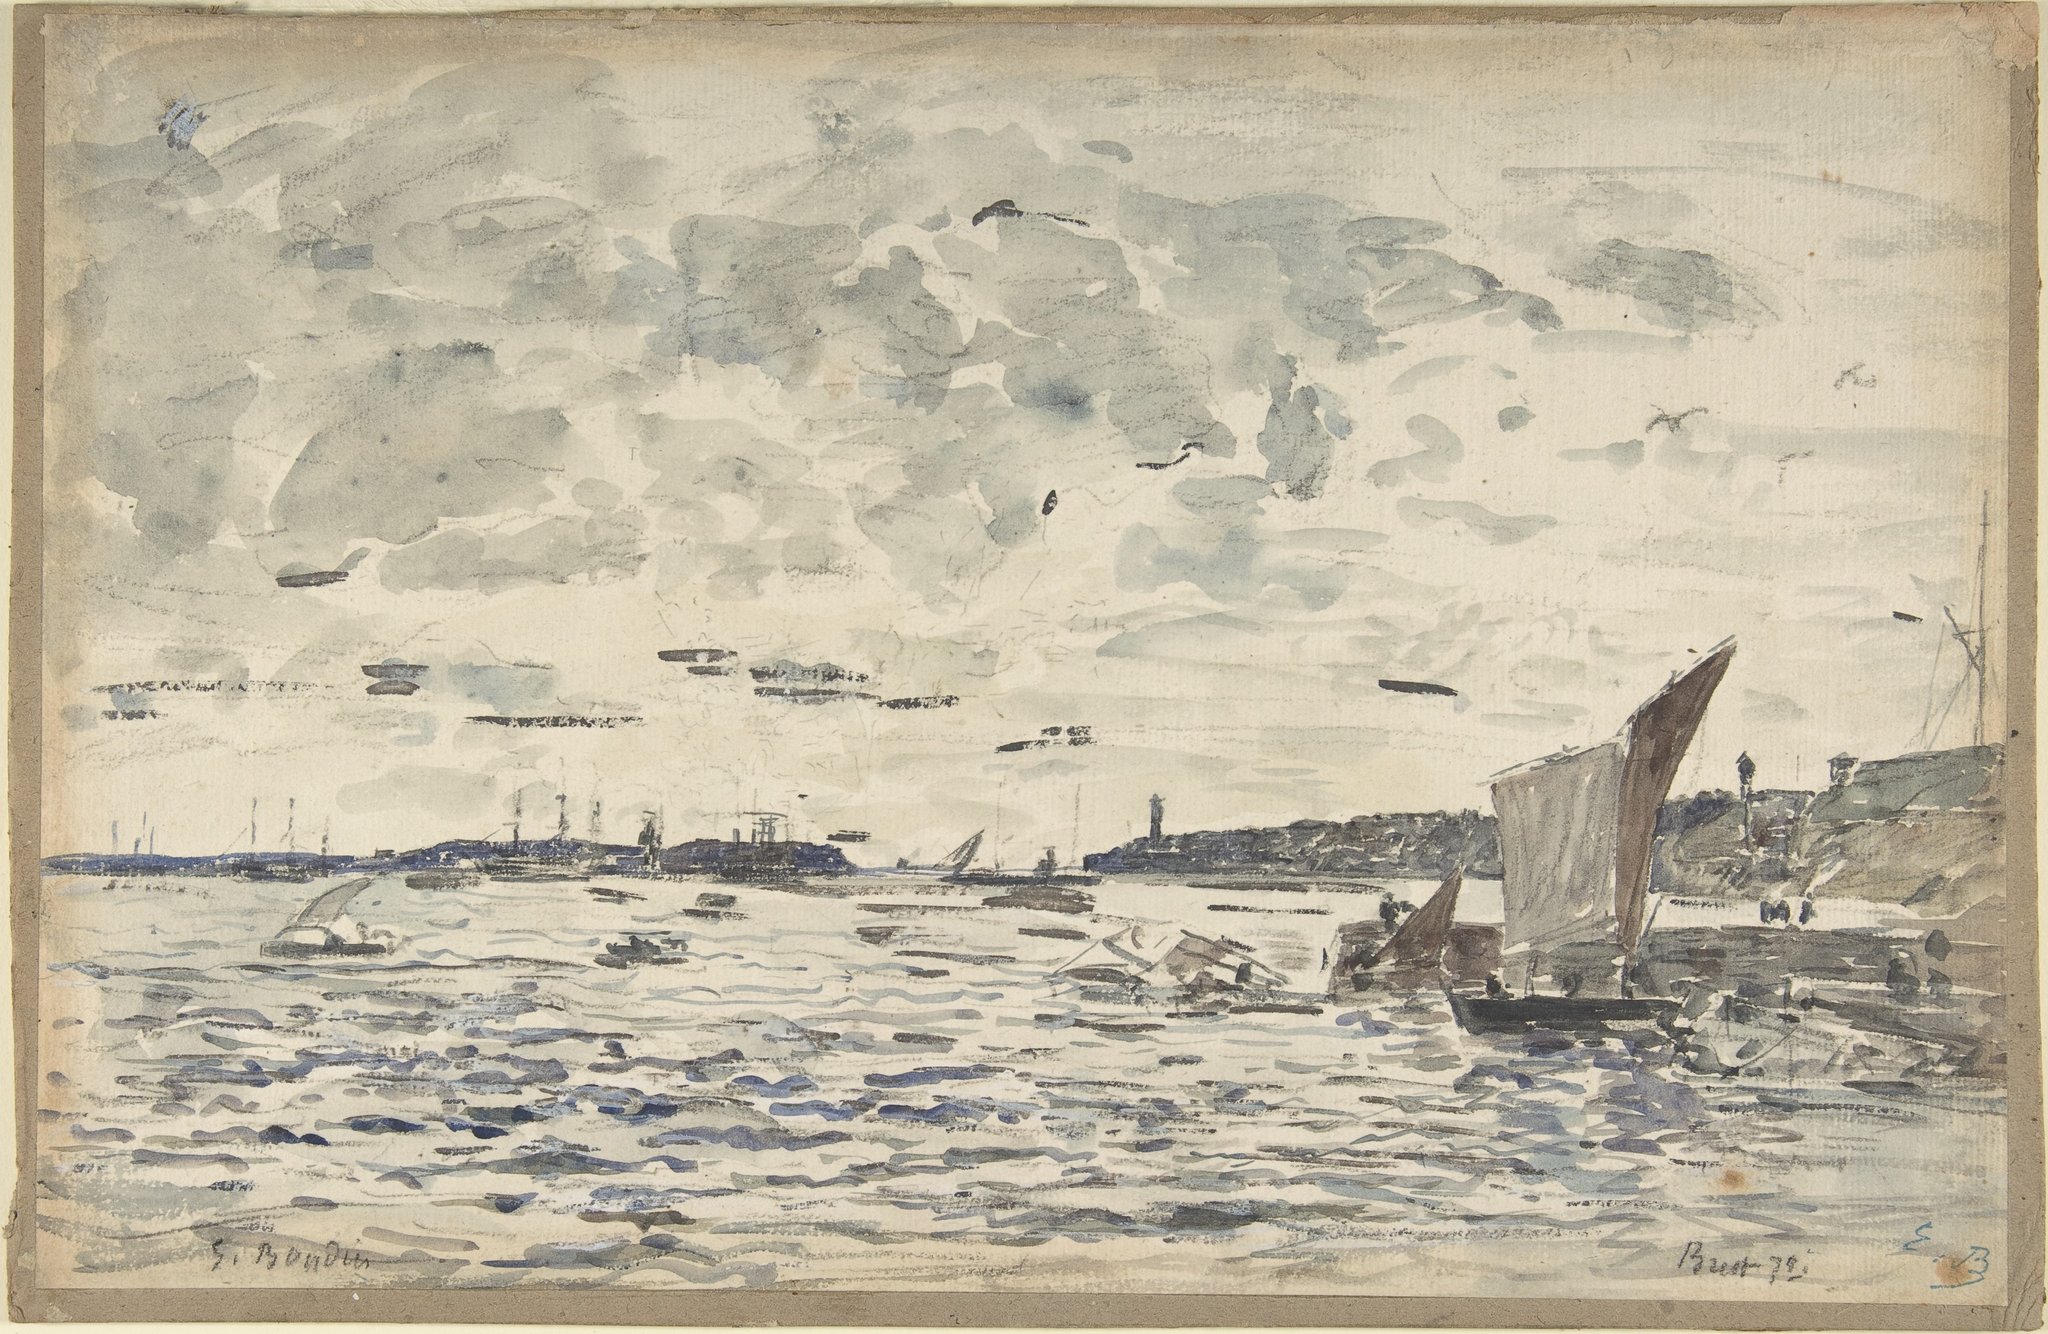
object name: drawing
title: Harbor, Brest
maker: eugène boudin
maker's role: artist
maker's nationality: french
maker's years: 1824-1898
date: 1840-1898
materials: chalk, gouache, watercolor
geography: france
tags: boats,harbors